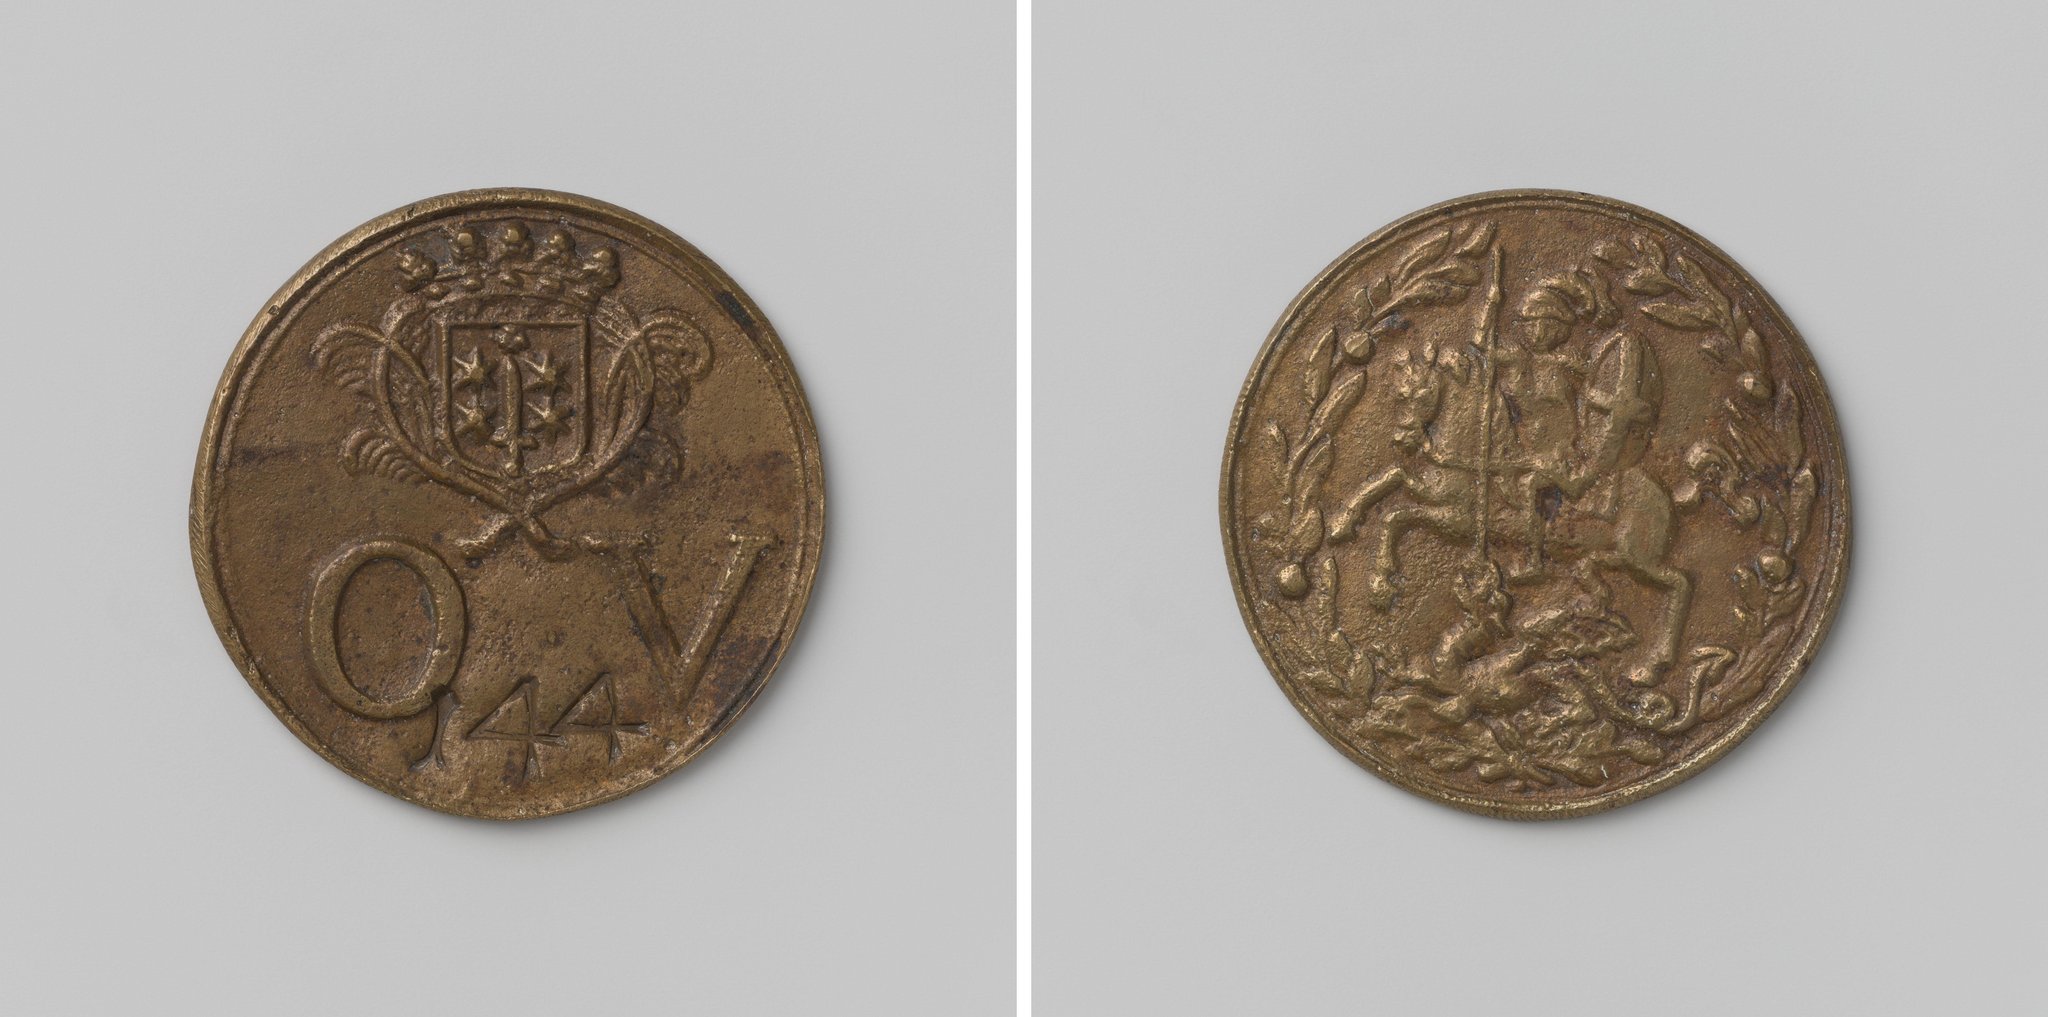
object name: marksman medal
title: Schutterij van Haarlem, schutterspenning van het Oranje Vaandel met no. 144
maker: Anonymous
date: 1650-1750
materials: brass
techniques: casting, engraving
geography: haarlem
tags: haarlem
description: Messing penning. Voorzijde: gekroond wapenschild op twee gekruiste palmtakken boven letters O en V; daartussen: cijfer 144. Keerzijde: gehelmde St. Joris te paard met schild in linkerhand doodt met speer ter aarde liggende draak